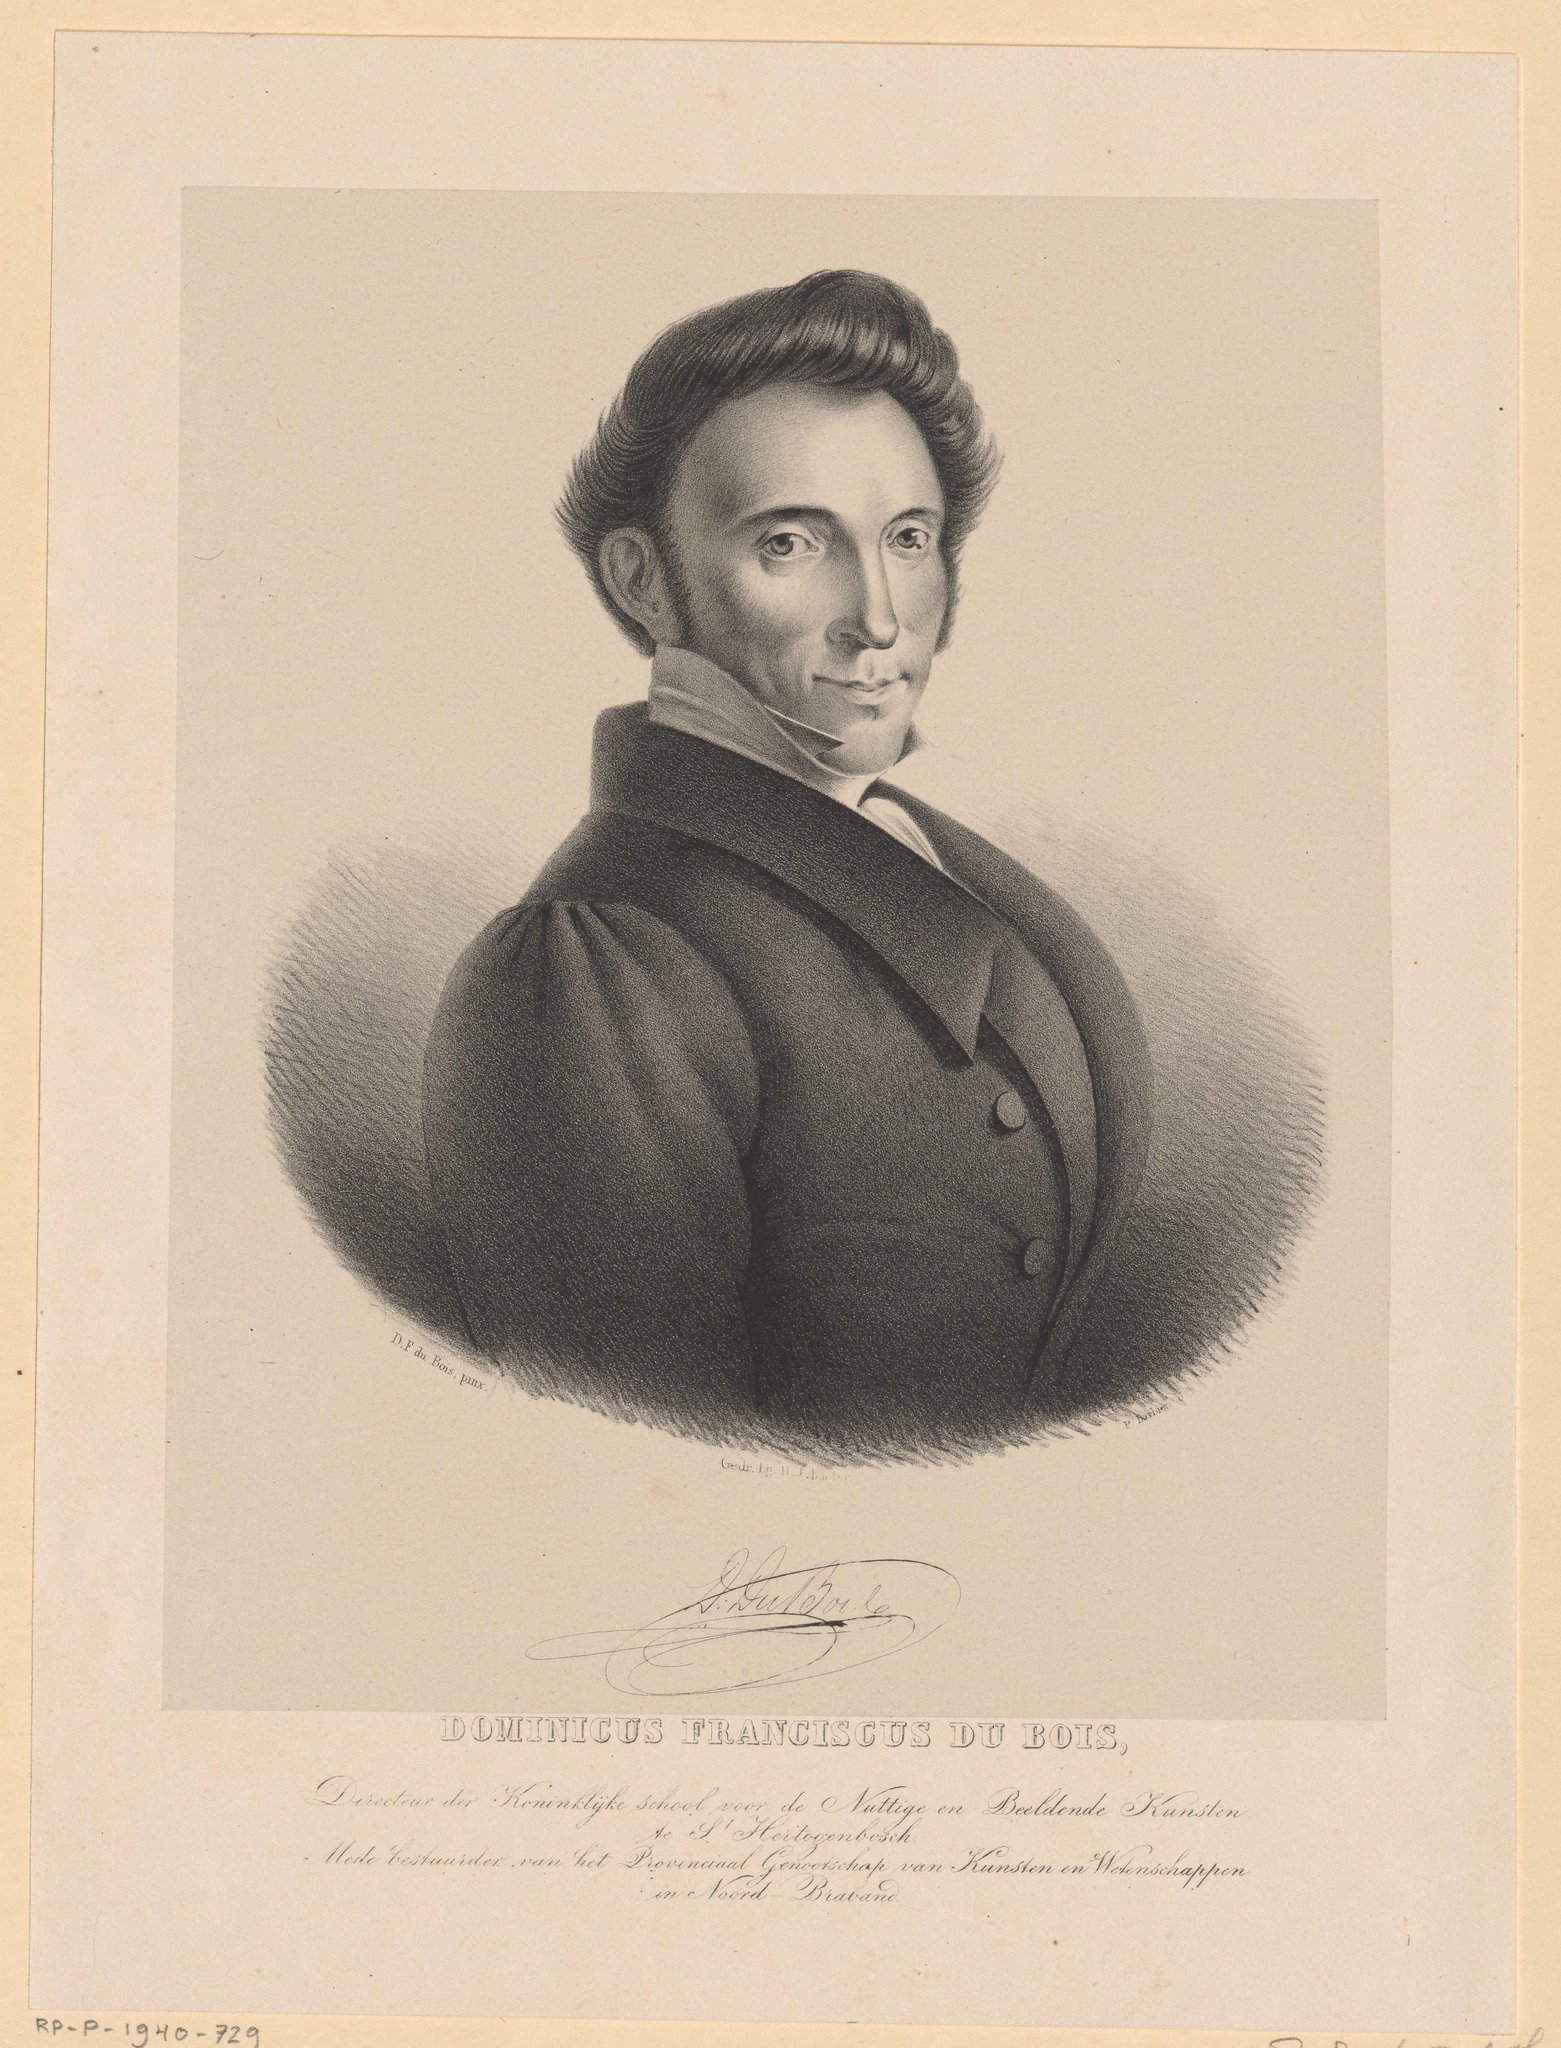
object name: print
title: Portret van Dominicus Franciscus du Bois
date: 1822-1845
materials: paper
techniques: lithograph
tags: bruges, den bosch, painter, draughtsman, dominicus franciscus du bois, historical persons, portrait, self-portrait of painter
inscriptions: collector's mark: Lugt 2228, collector's mark: Lugt 2760